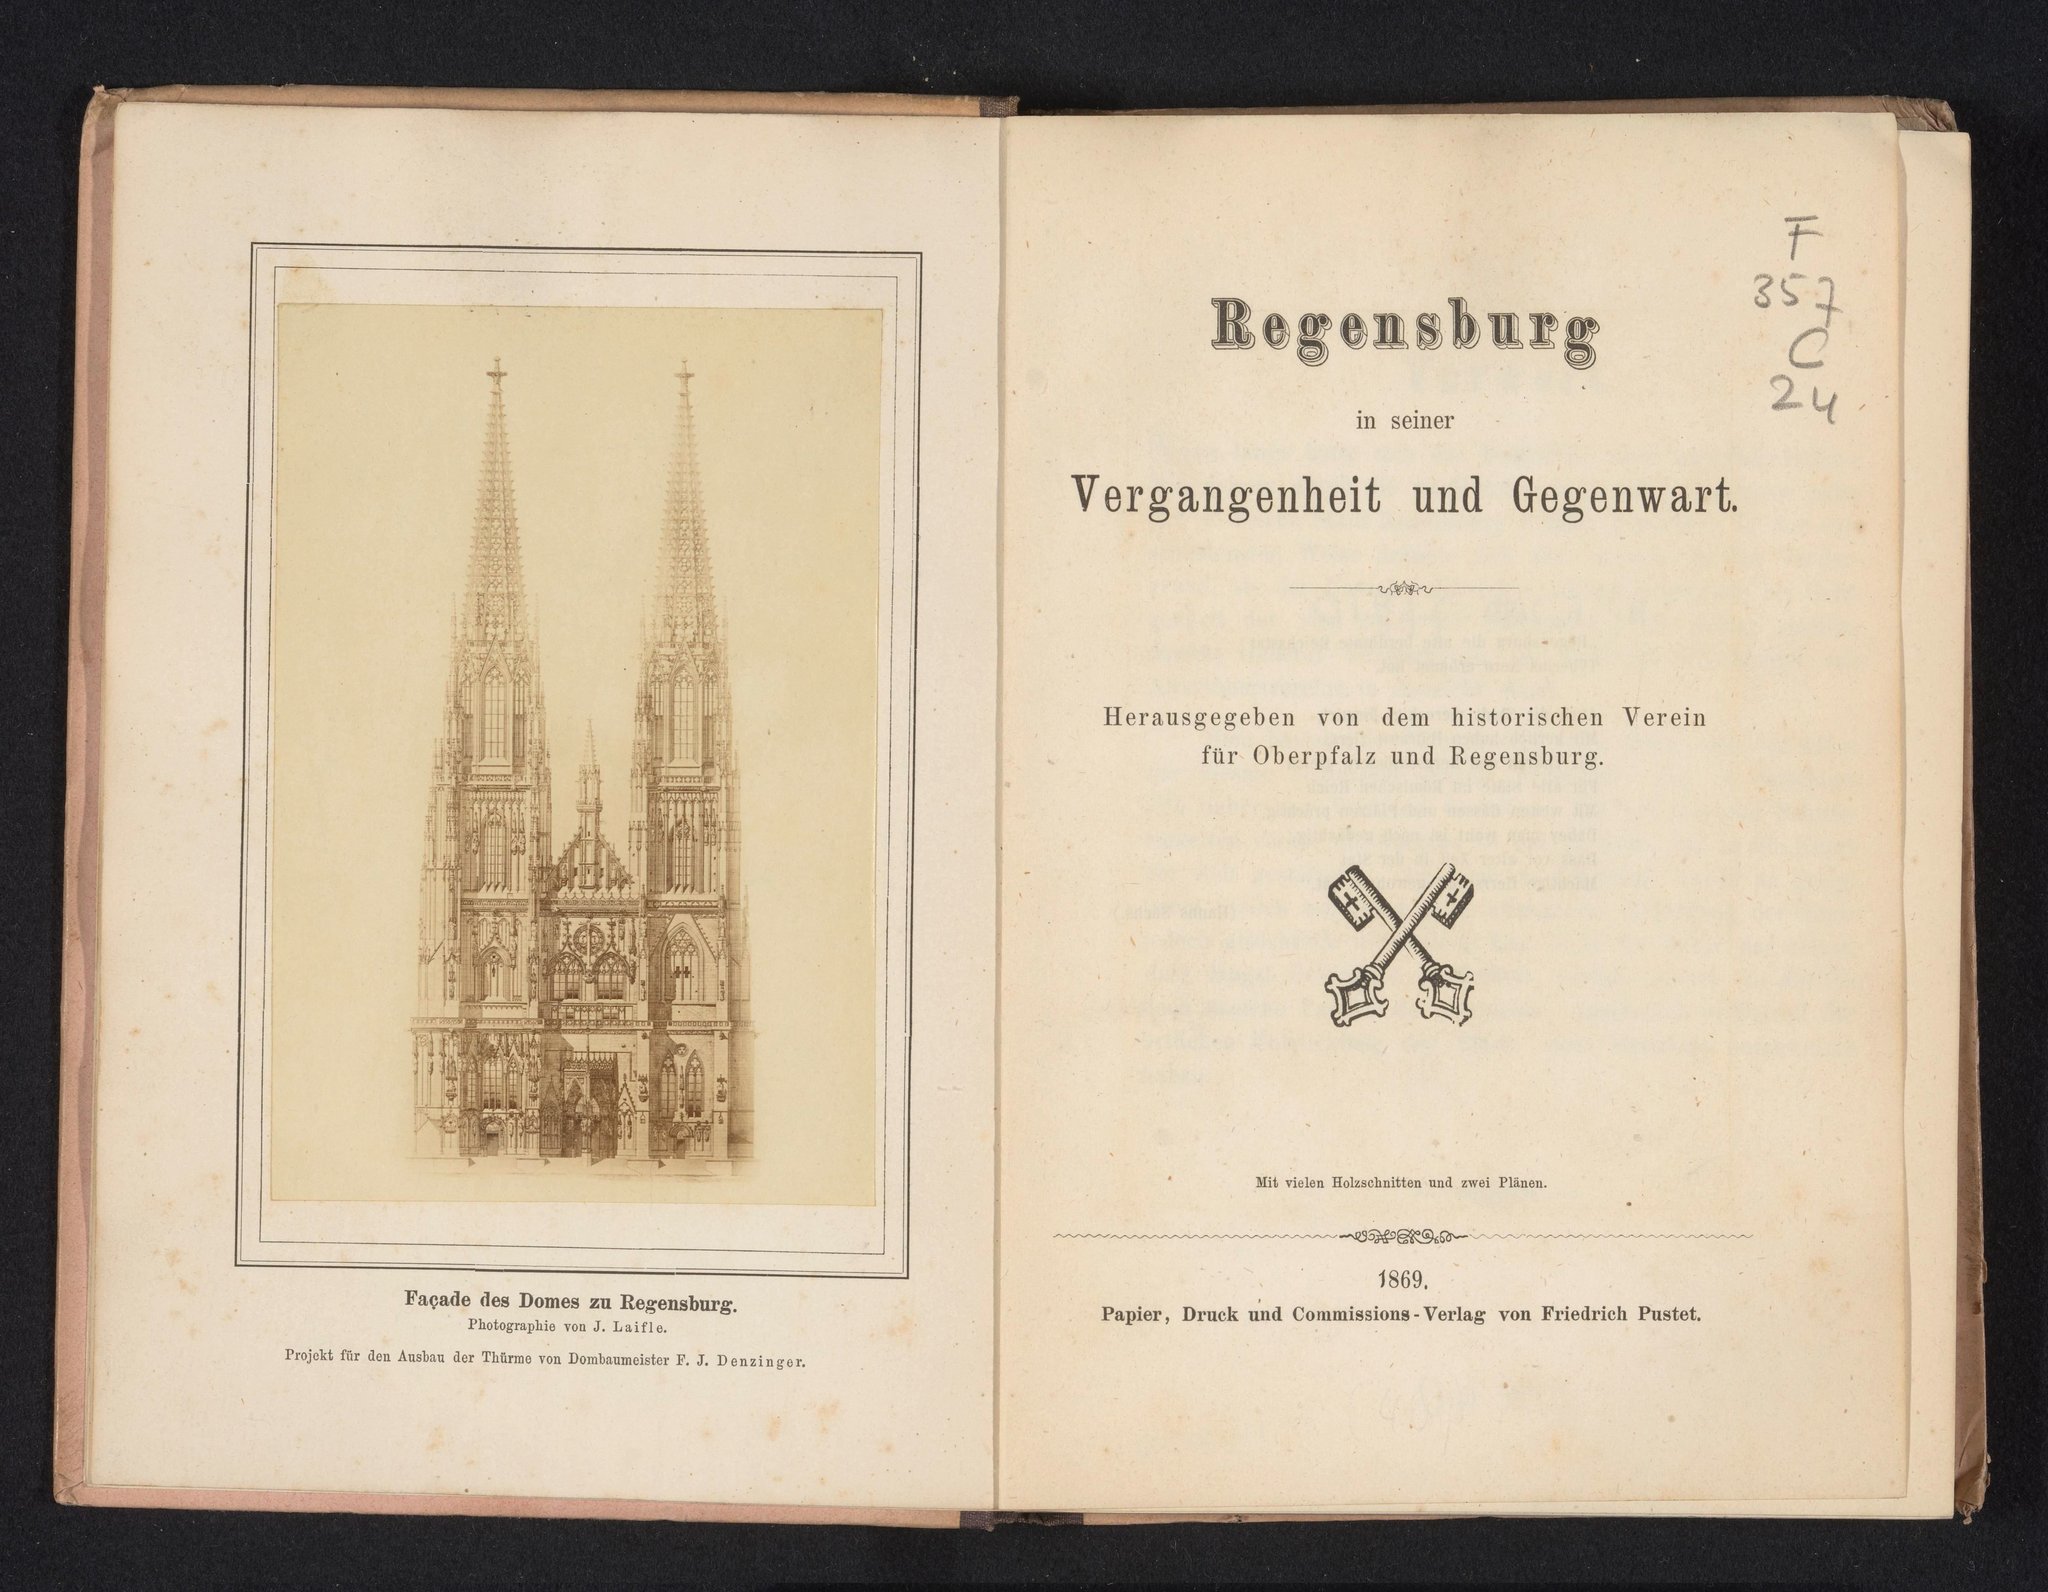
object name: reproduction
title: Fotoreproductie van een prent, voorstellende de voorgevel van de Dom van Regensburg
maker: johann laifle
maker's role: fotograaf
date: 1864-1869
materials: photographic support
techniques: albumen print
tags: church (exterior), façade (of house or building)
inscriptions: inscription: ‘Projekt für (...) Denzinger.’